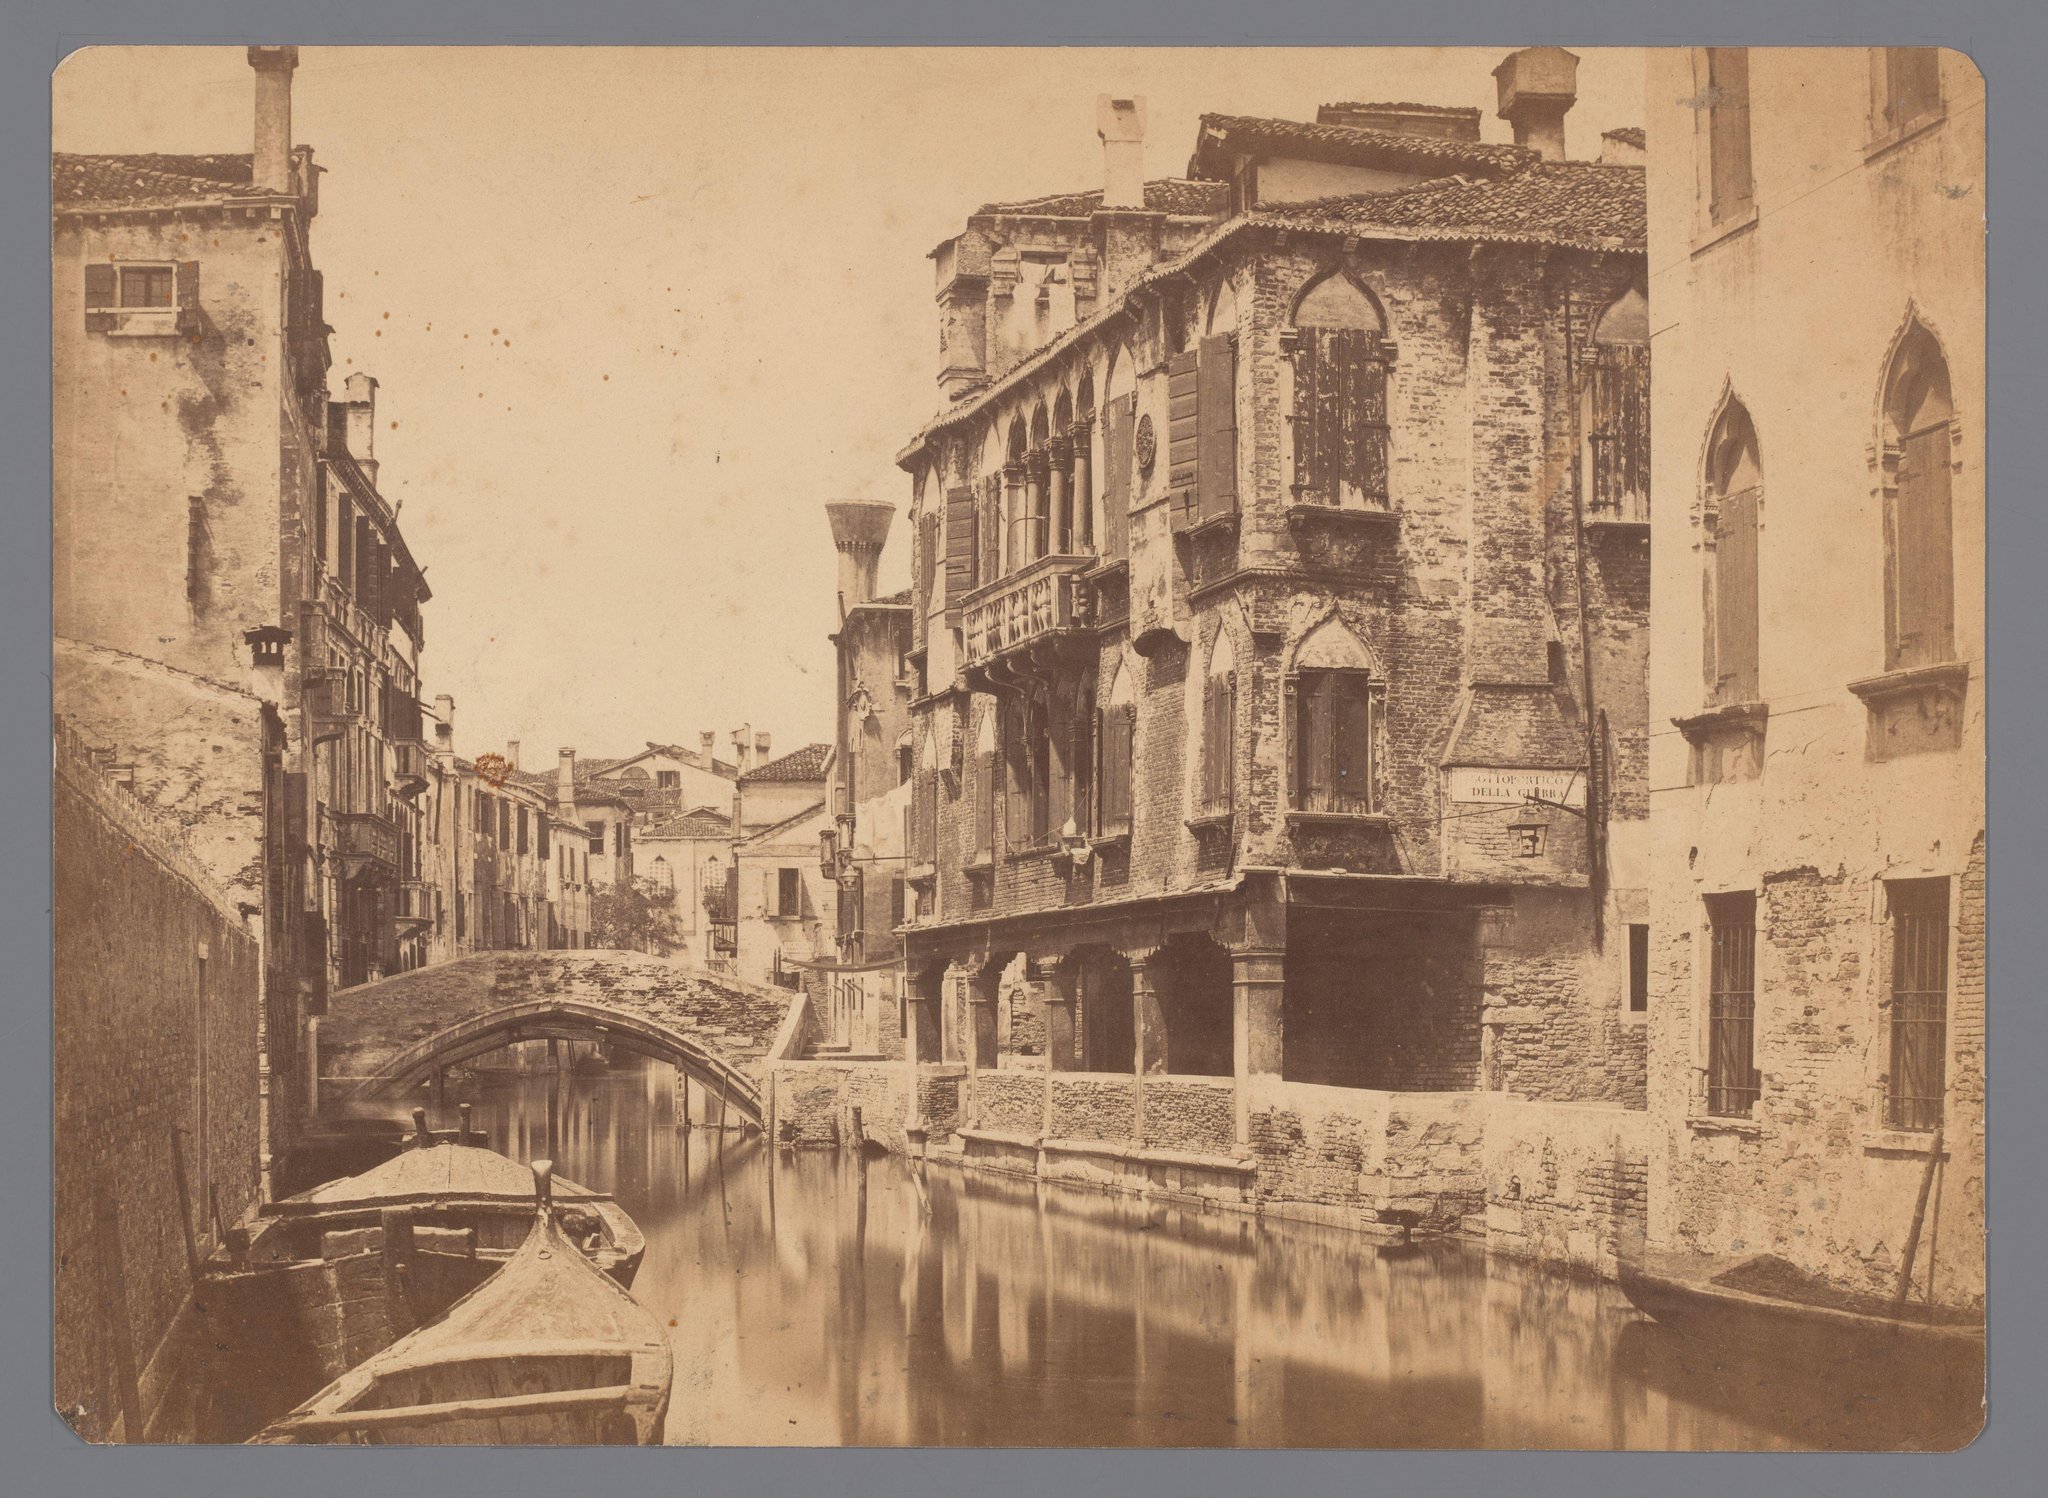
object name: photograph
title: Kanaal te Venetië, Italië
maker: Anonymous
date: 1851-1900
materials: cardboard, paper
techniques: albumen print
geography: venice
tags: canals, waters (in city), venice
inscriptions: inscription: ‘Venetië’